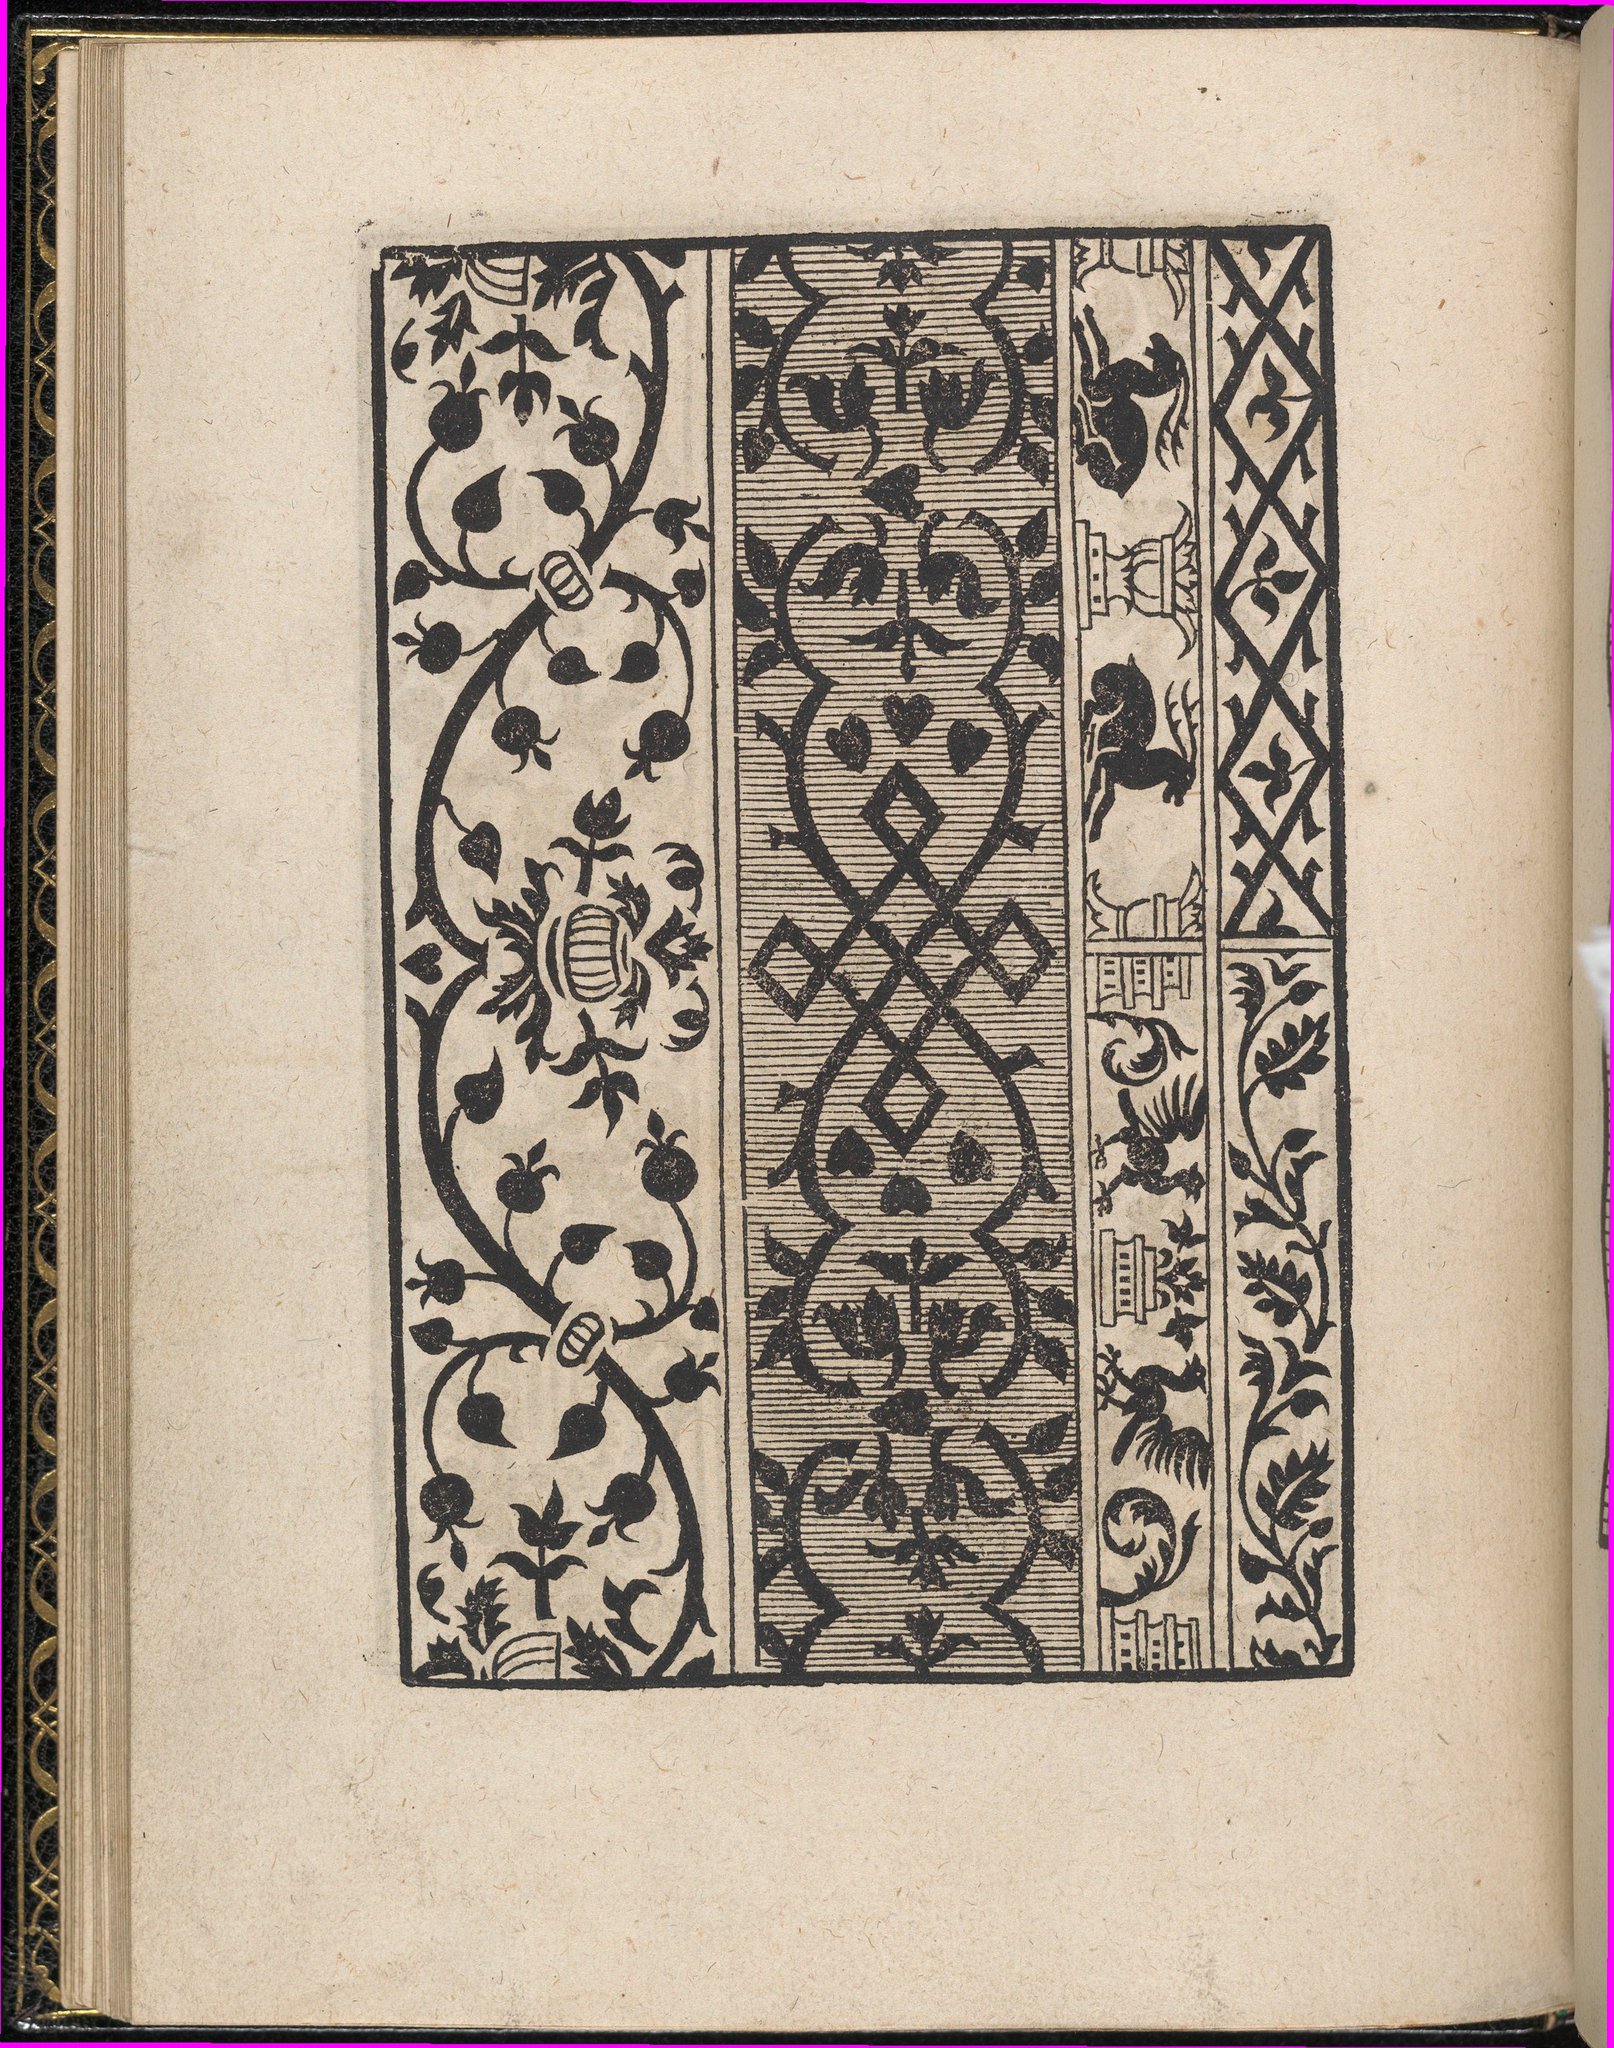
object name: book print ornament architecture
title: Page from Ein new kunstlich Modelbuch...(Page 19v)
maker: peter quentel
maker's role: publisher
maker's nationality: german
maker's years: 1500-1550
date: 1544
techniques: woodcut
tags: birds,deer